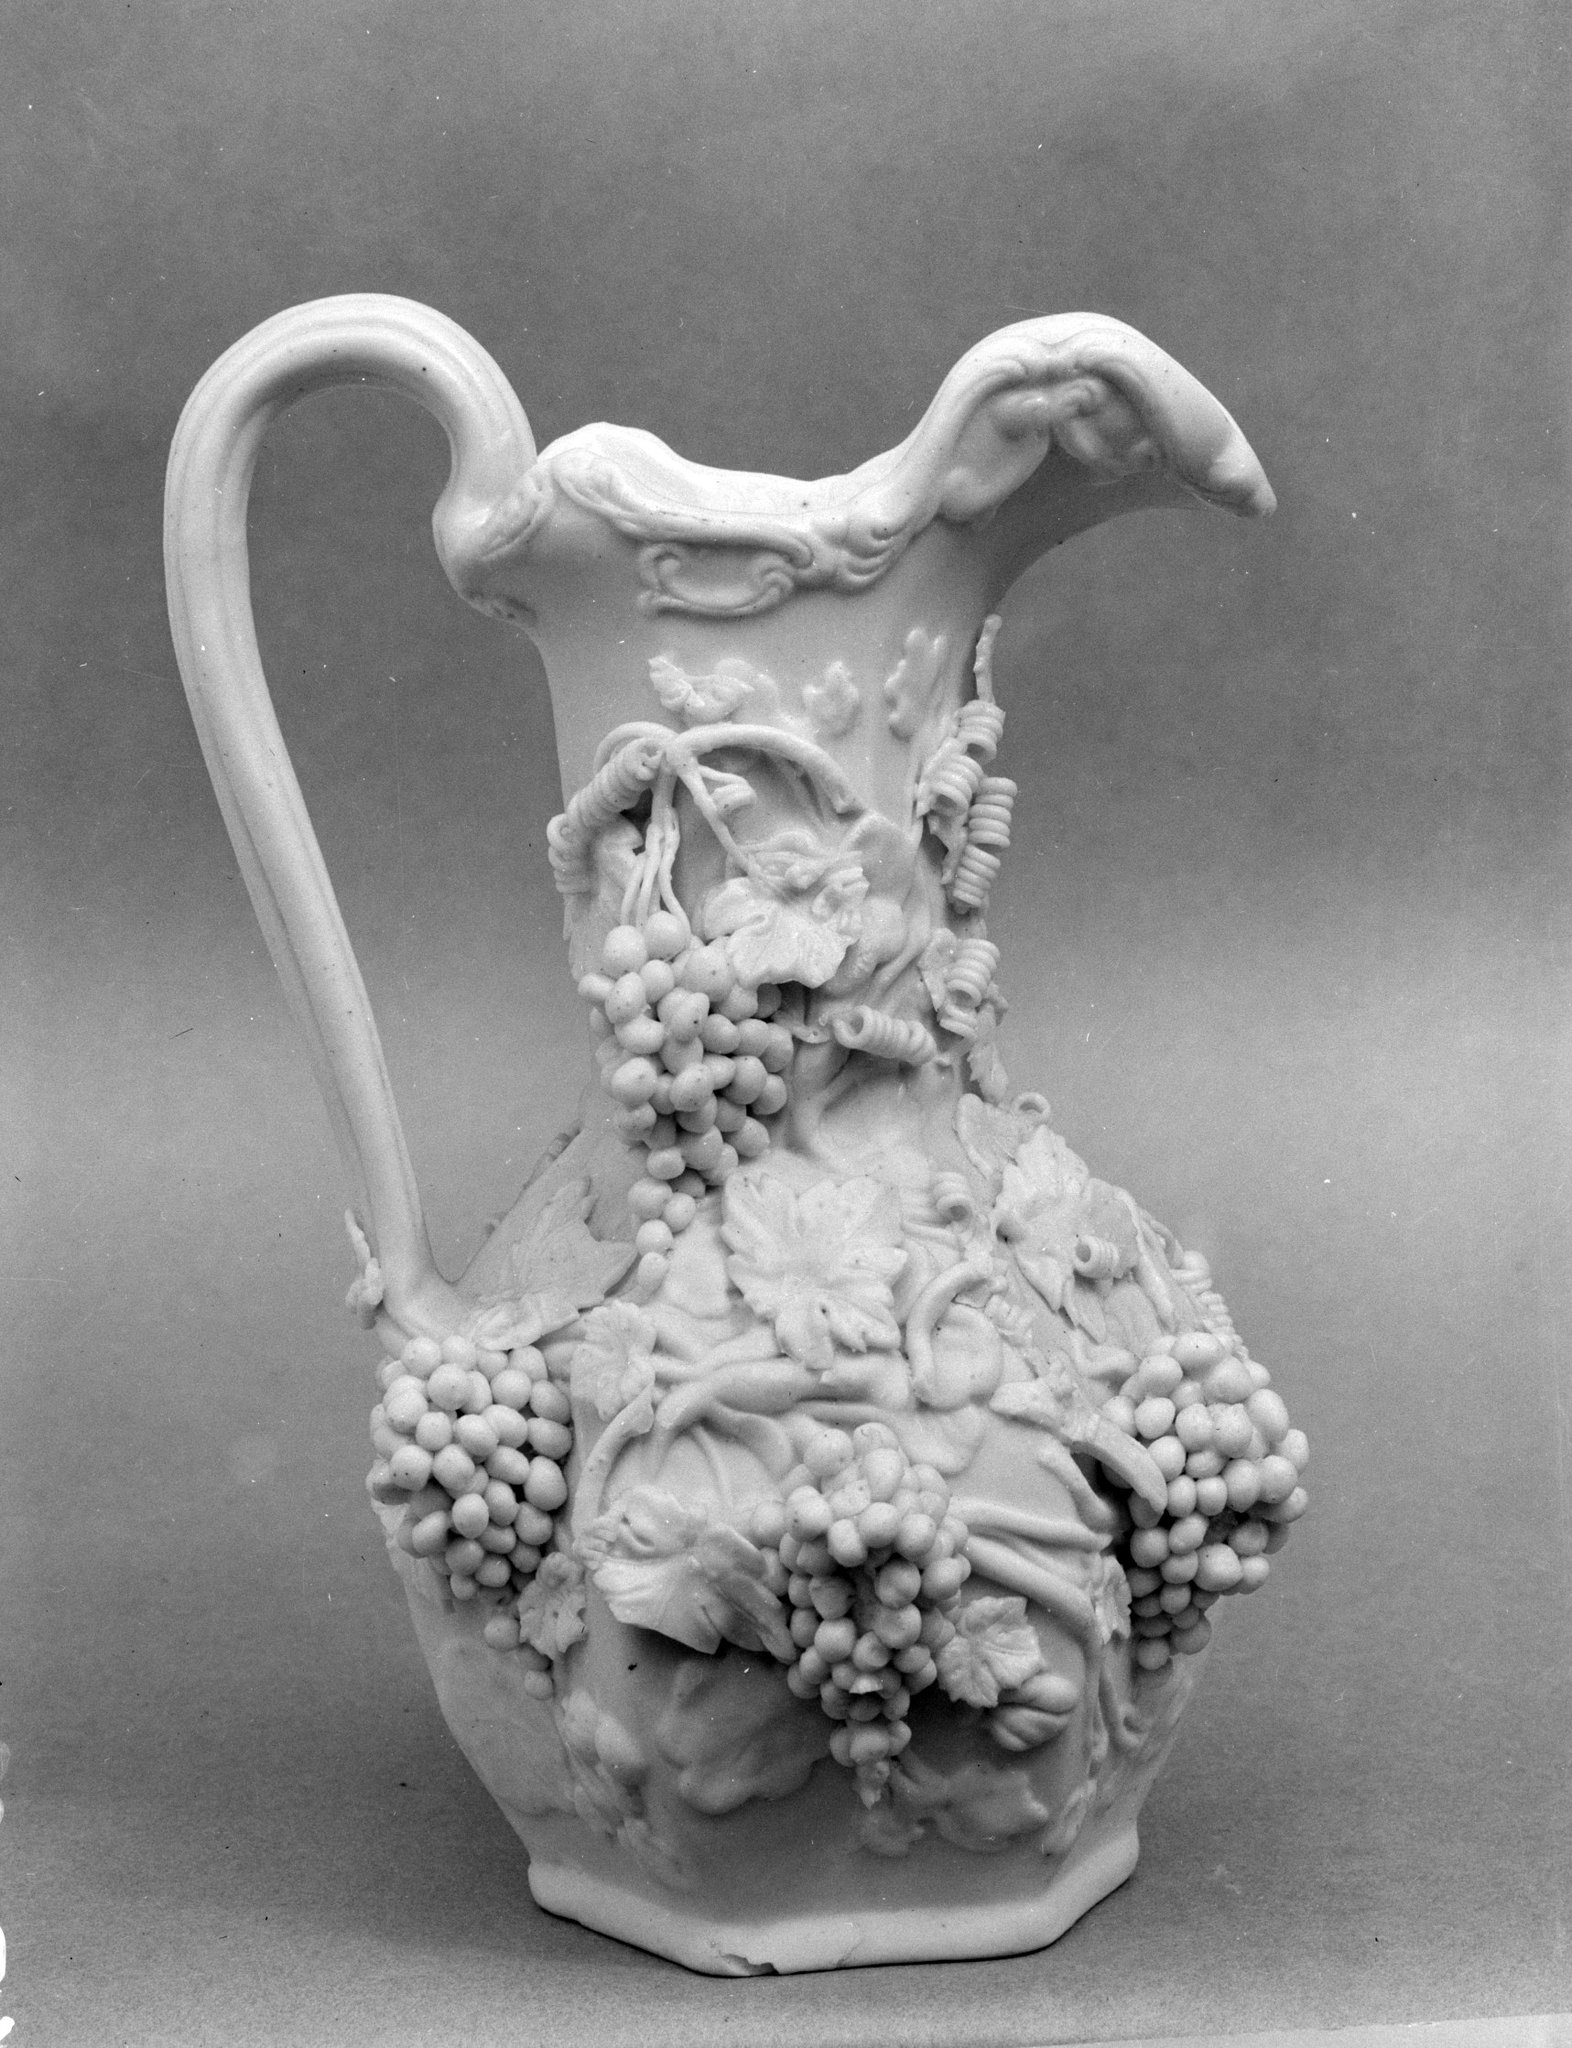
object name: pitcher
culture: american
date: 1830-1870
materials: porcelain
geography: united states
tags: grapes